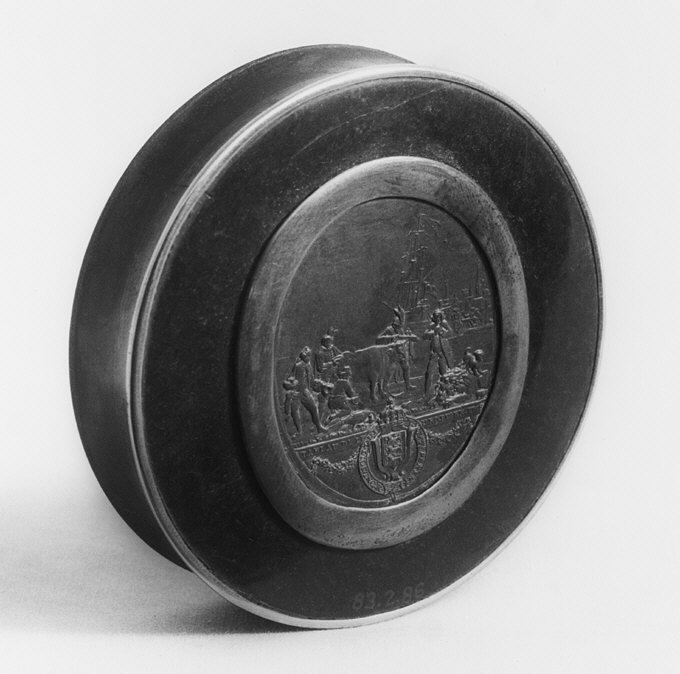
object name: box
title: Box with Medallion Top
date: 1770-1800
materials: copper, shell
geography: england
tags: men,cows